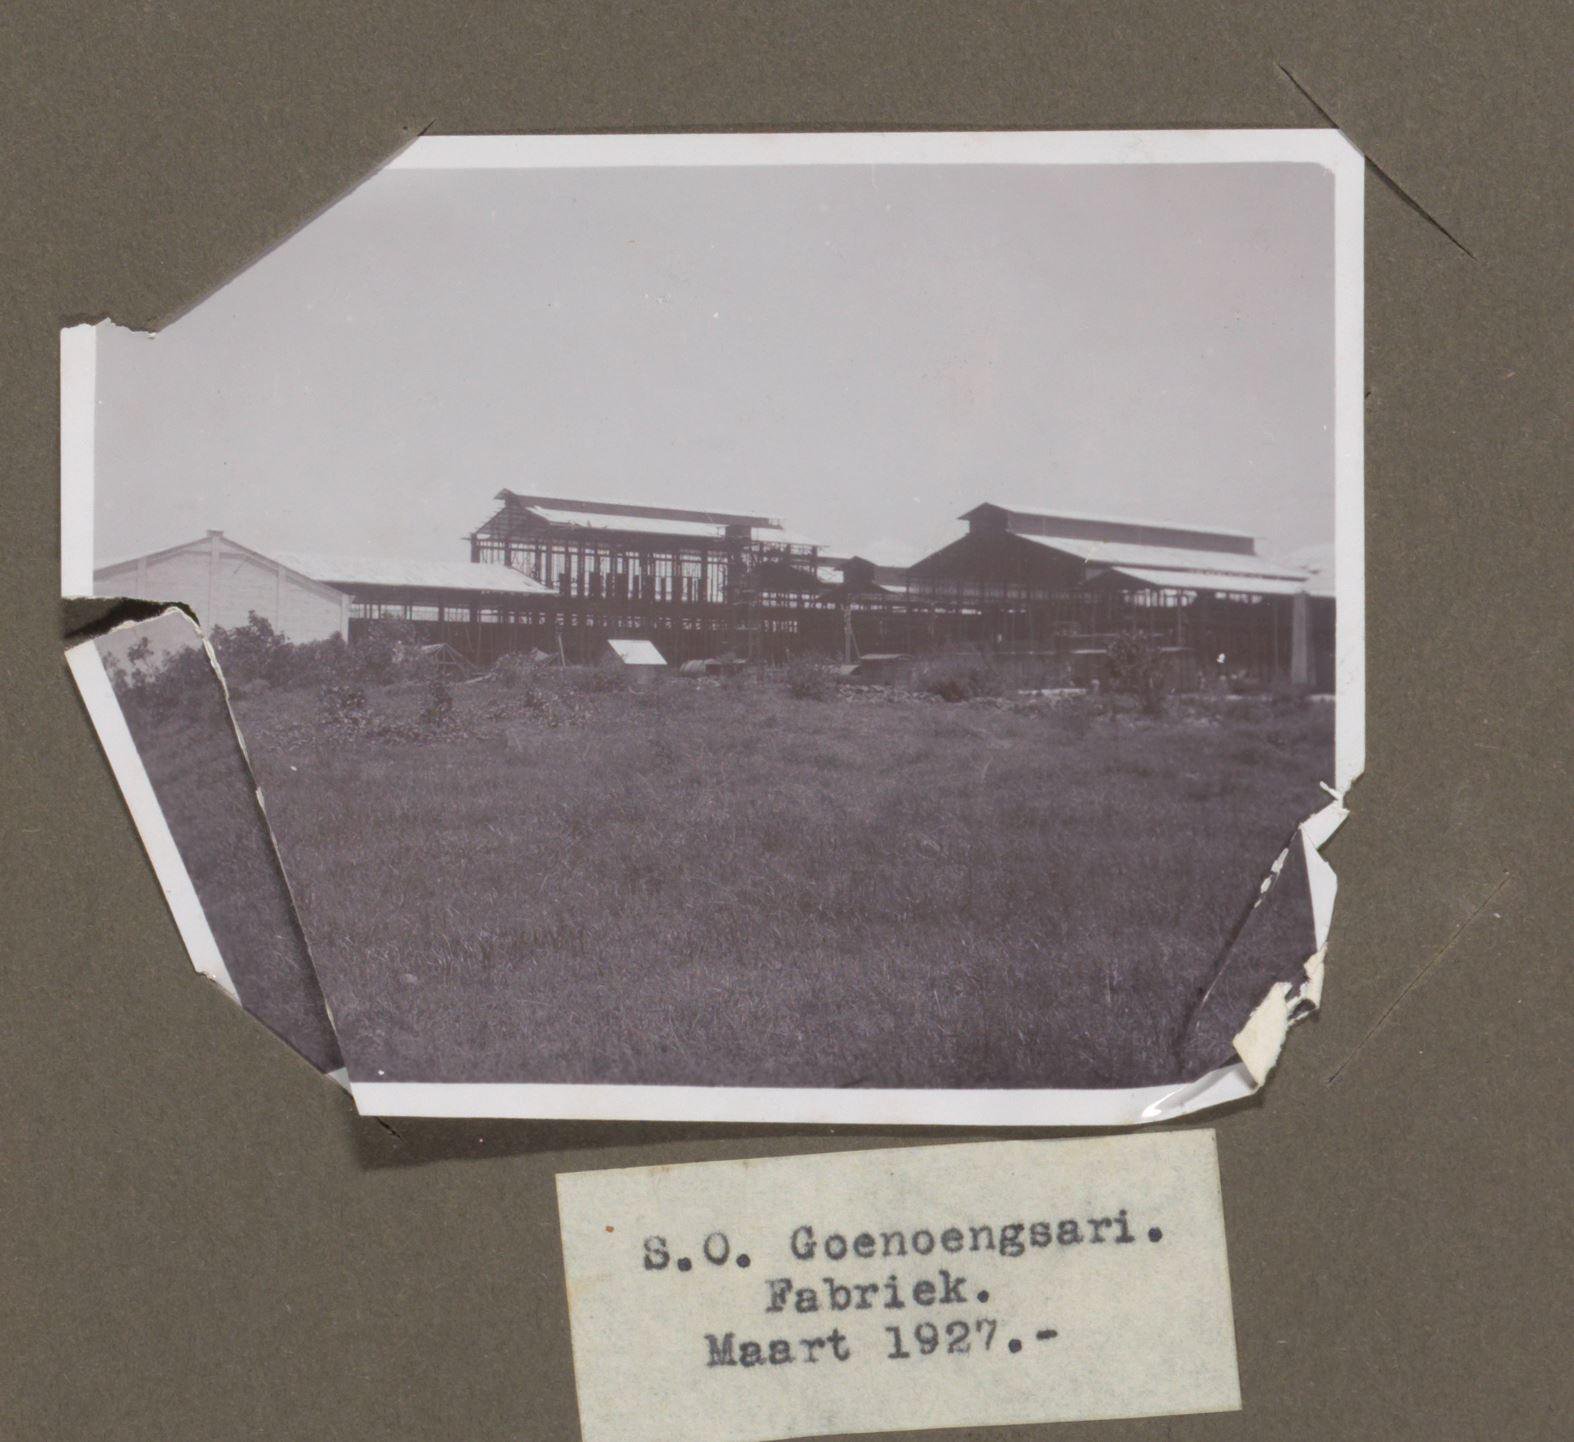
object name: photograph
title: S.O. Goenoengsari. Fabriek. Maart 1927.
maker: Anonymous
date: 1903-1927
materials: photographic support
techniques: gelatin silver print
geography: east java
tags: colonial system, trade-company, making the overground structures (~ building activities), (non-fruit) products of plants or trees: sugarcane, exterior of industrial structures, factories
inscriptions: inscription: ‘S.O. Goenoengsari. Fabriek. Maart 1927.’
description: Gezicht op de fabrieksgebouwen in aanbouw, maart 1927. De fotoafdruk is wat gescheurd en verfomfaaid. Onderdeel van het fotoalbum met foto's van de opbouw van de suikerfabriek te Goenoengsari op Oost-Java door de Handels Vereniging Amsterdam 1926-1927.